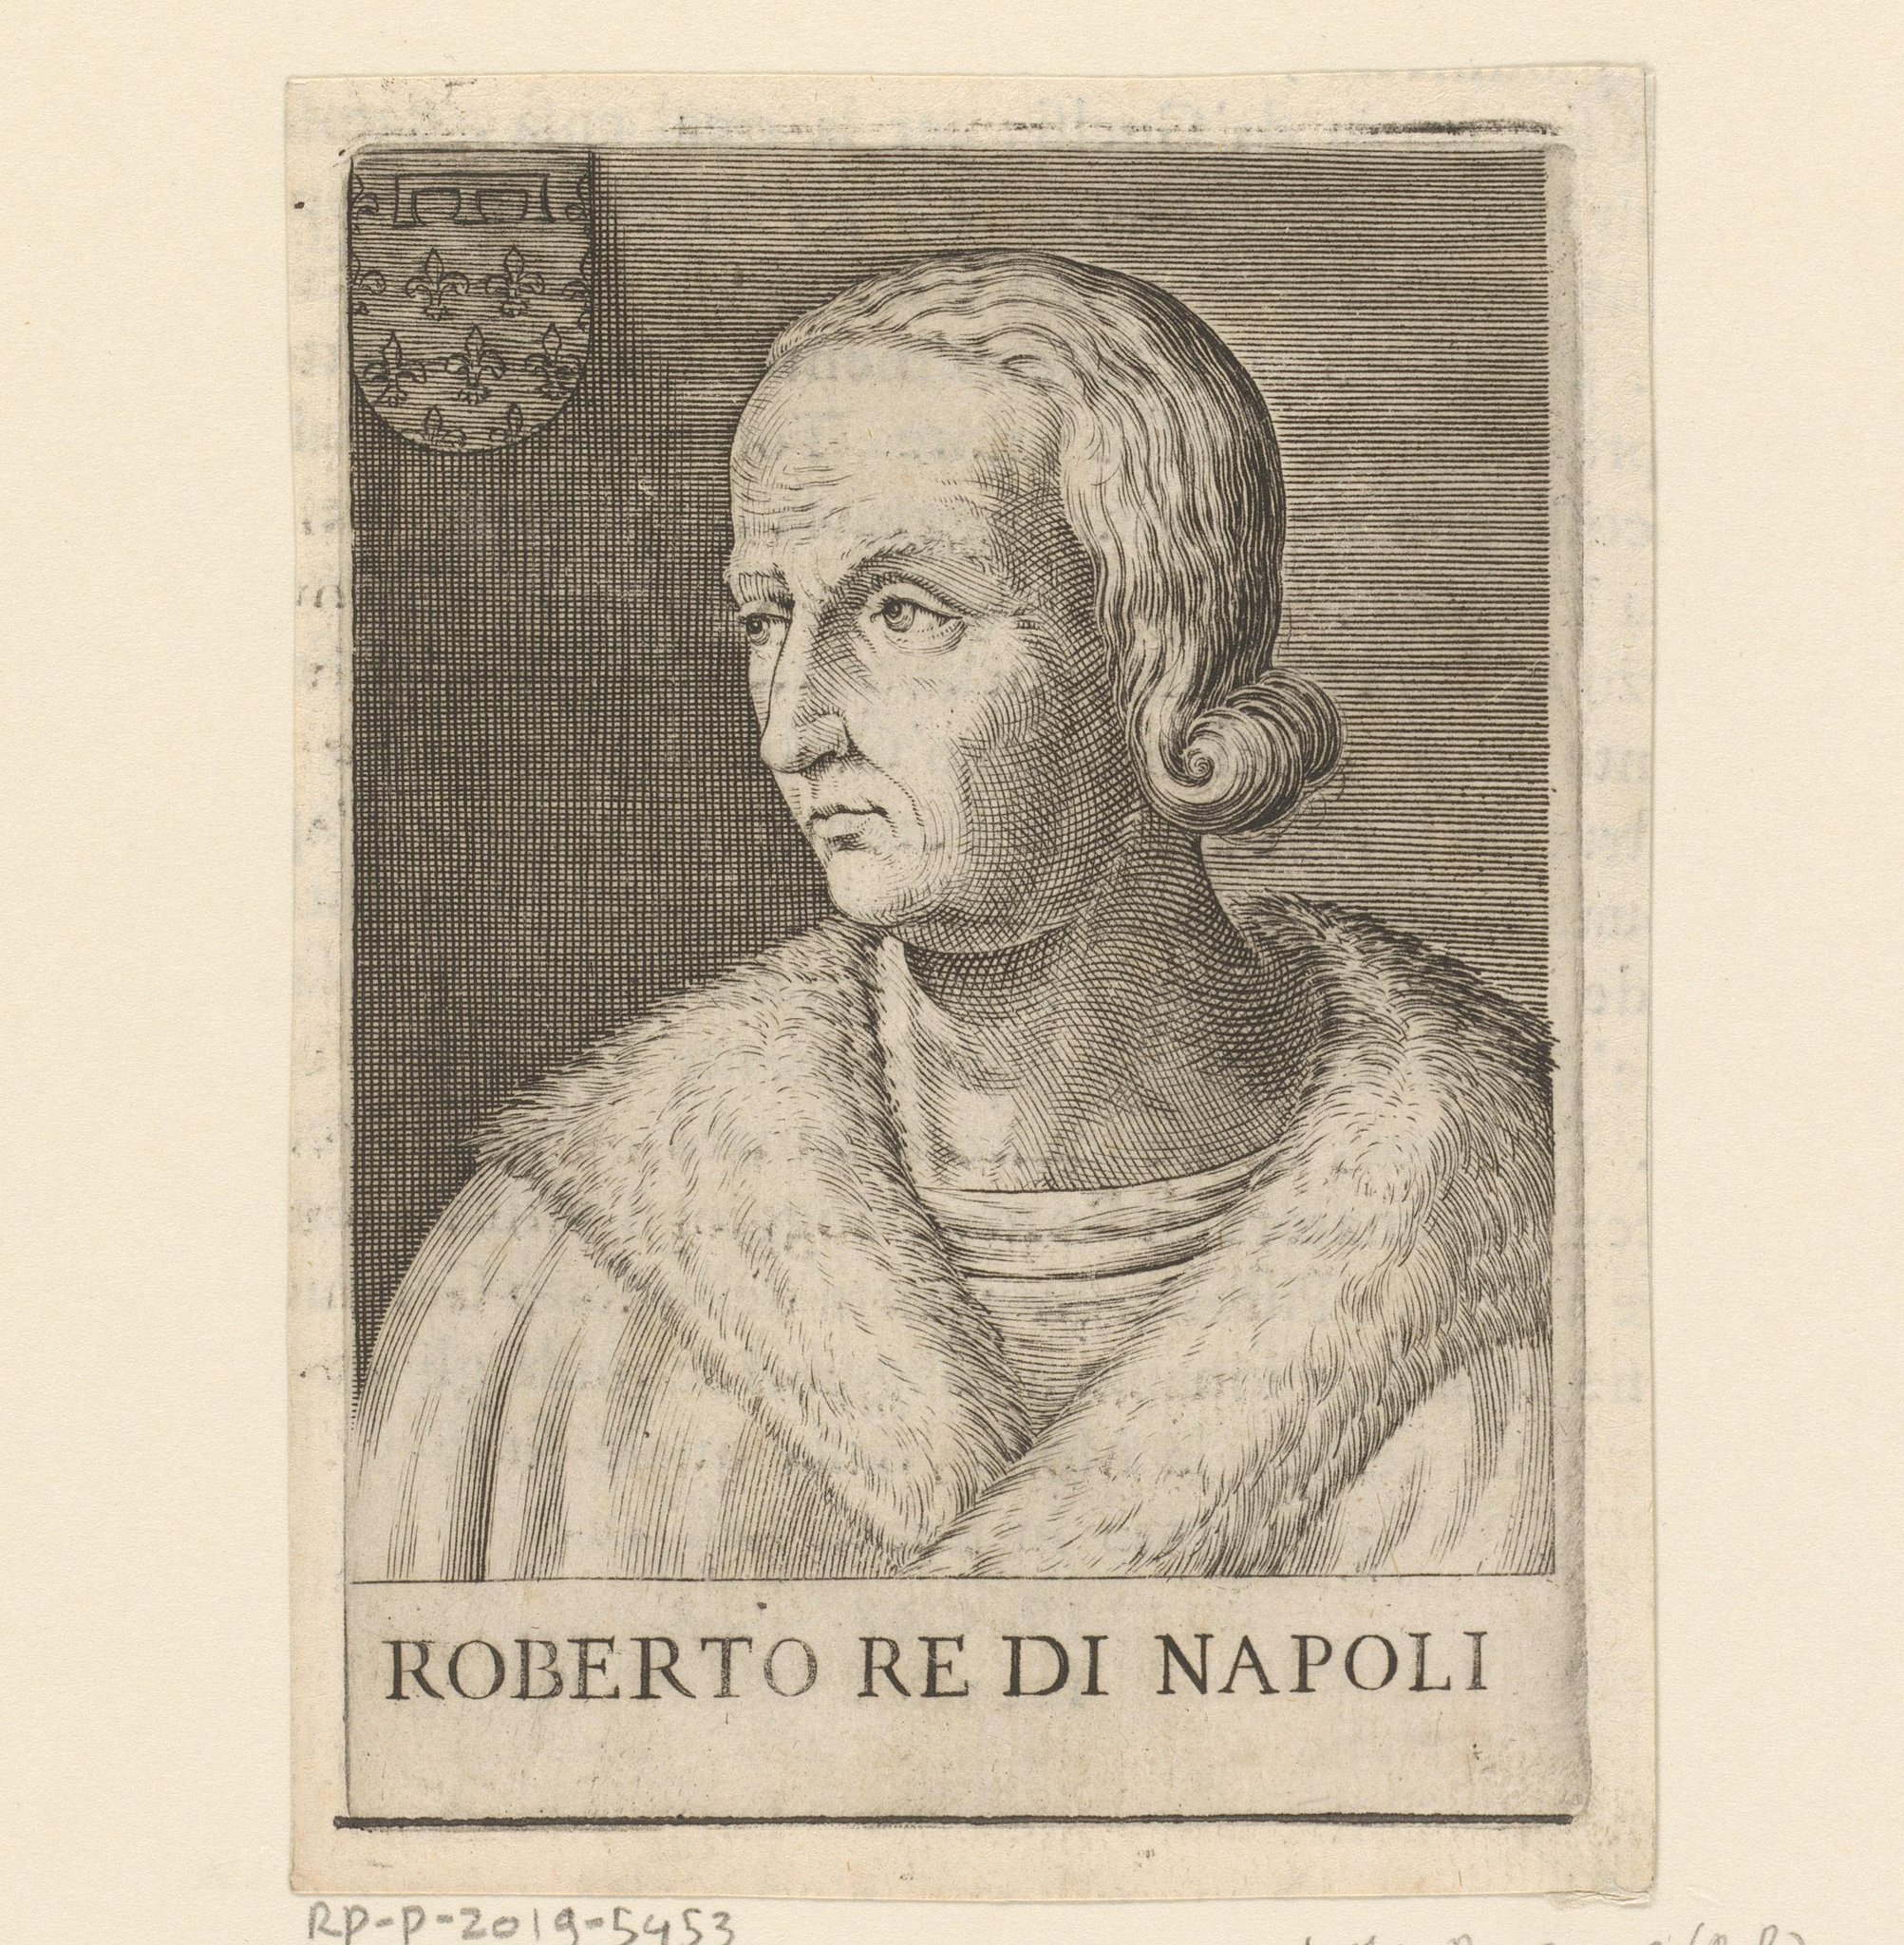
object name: book illustration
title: Portret van Robert, koning van Napels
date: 1646-1647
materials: paper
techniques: engraving, letterpress printing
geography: rome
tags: historical persons, king, armorial bearing, heraldry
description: Prent uit: Ritratti et elogii di capitani Illustri. Che ne'secoli moderni hanno gloriosamente guerreggiato. Rome: Filippo de'Rossi en Vitale Mascardi, 1646, p. 38. Prent ook gebruikt in dezelfde editie van 1647. Eerdere staten van prent in ieder geval gebruikt in: Ritratti et elogii di capitani Illustri. Rome: Pompilio Totti en Andrea Fei, 1635. En in: Ritratti di cento capitani illustri con li lor Fatti in guerra (…), Rome: Domenico Gigliotti, 1596.